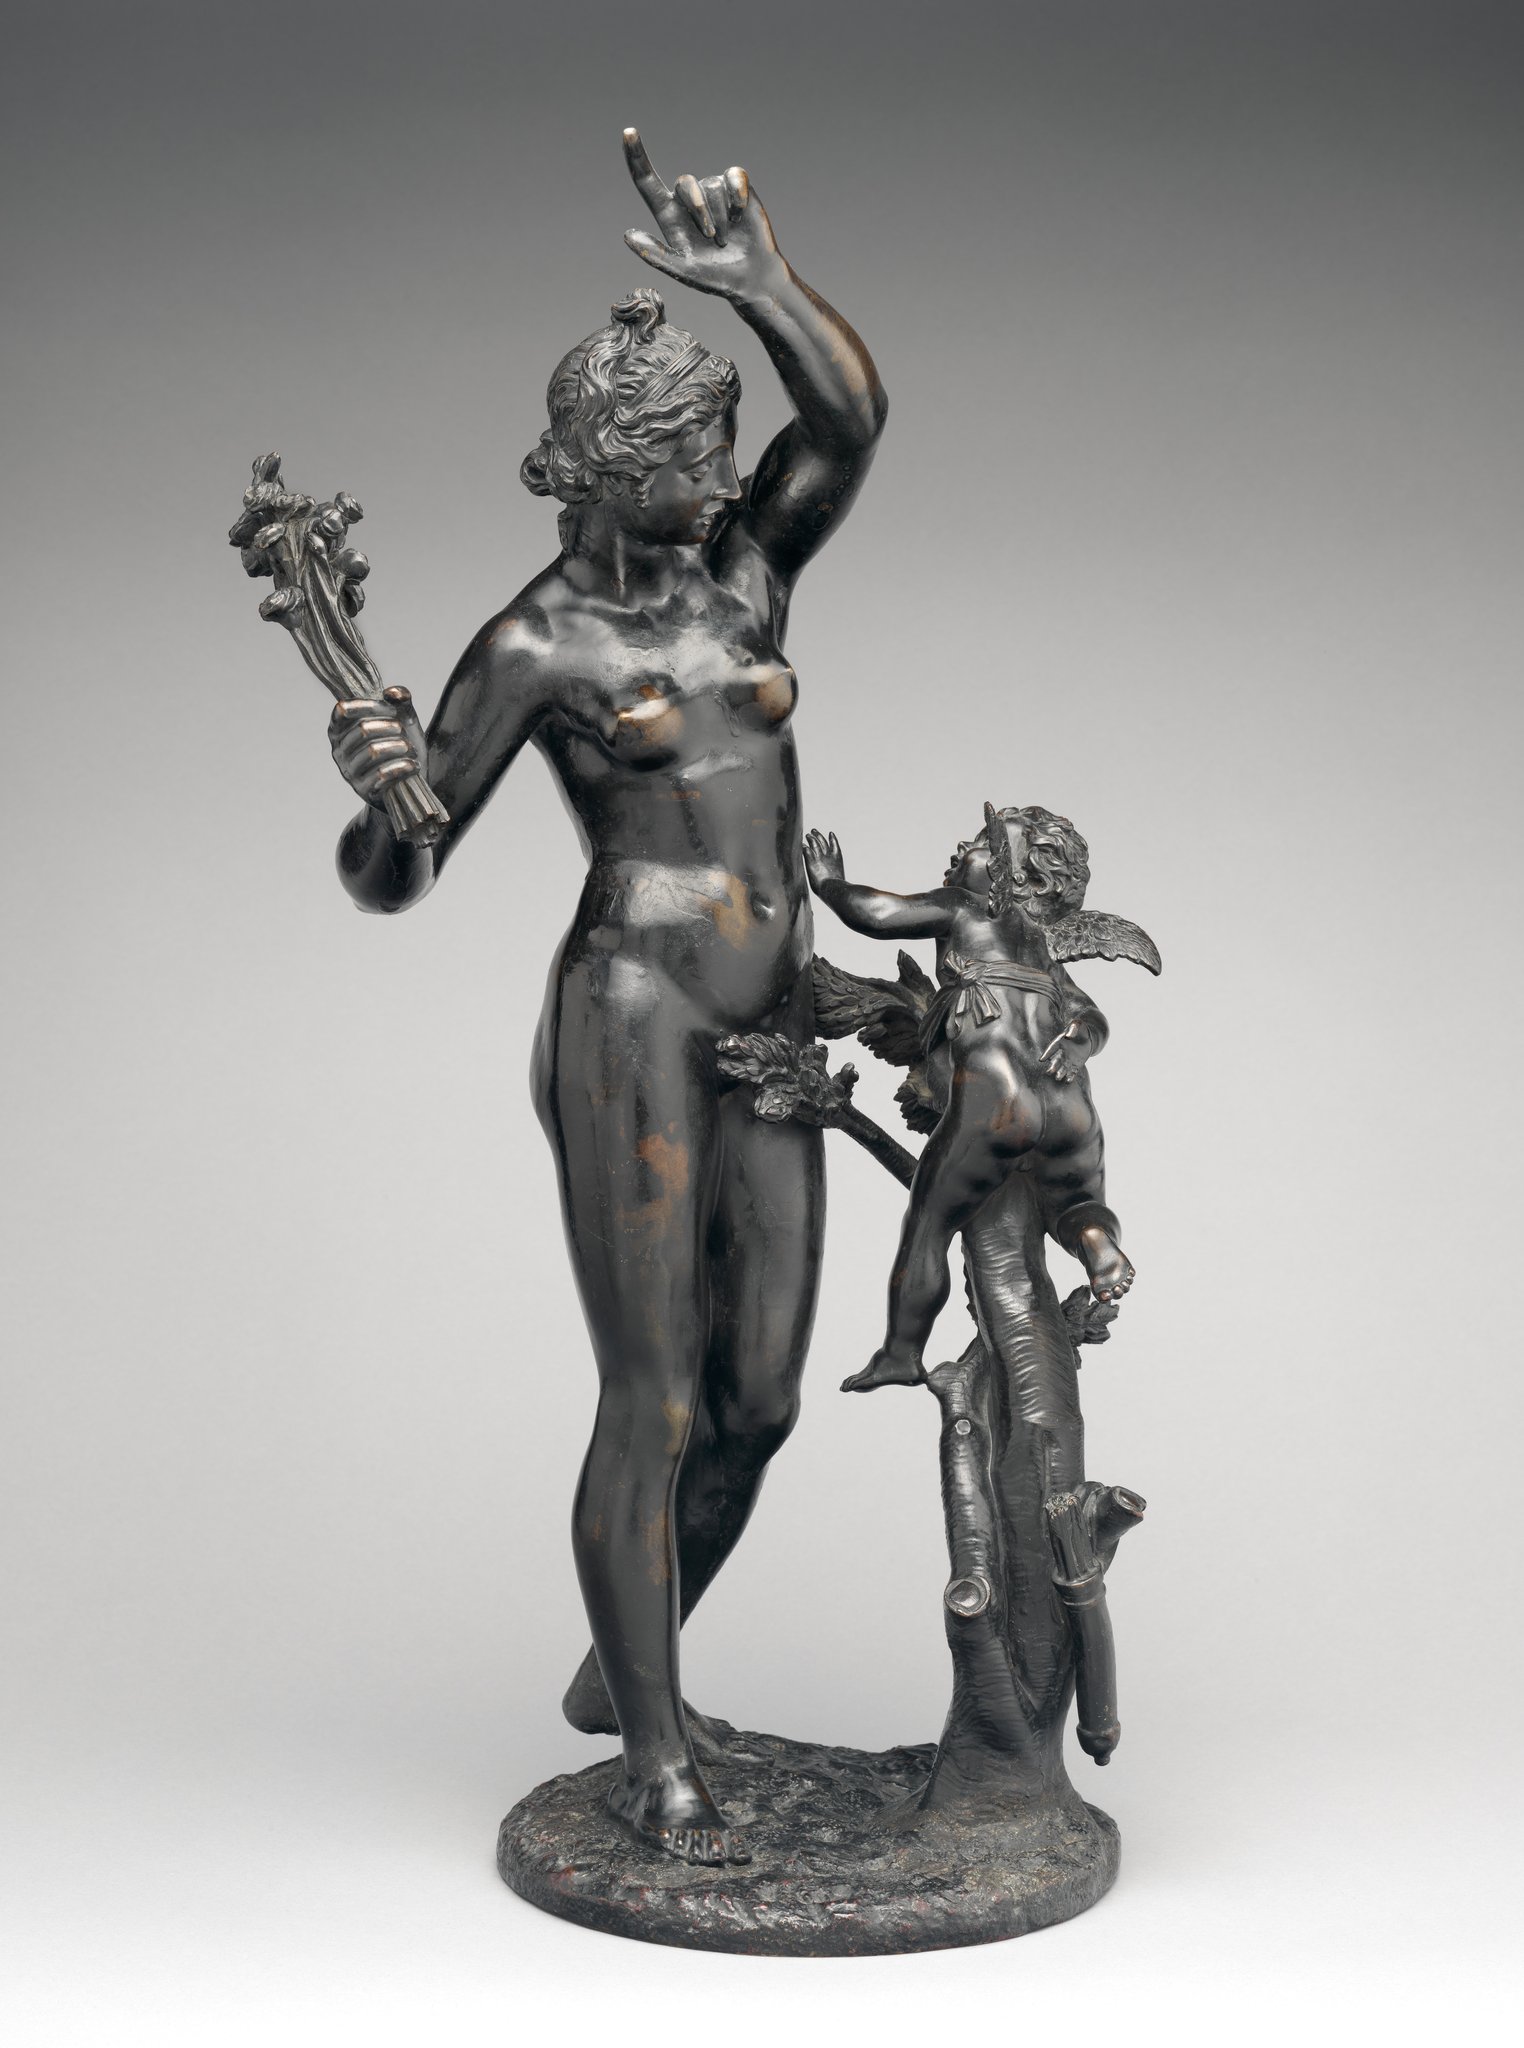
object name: statuette group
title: Venus chastening Cupid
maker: giovanni francesco susini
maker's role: artist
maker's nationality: italian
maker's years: 1585-1653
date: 1867-1900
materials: bronze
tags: cupid,venus